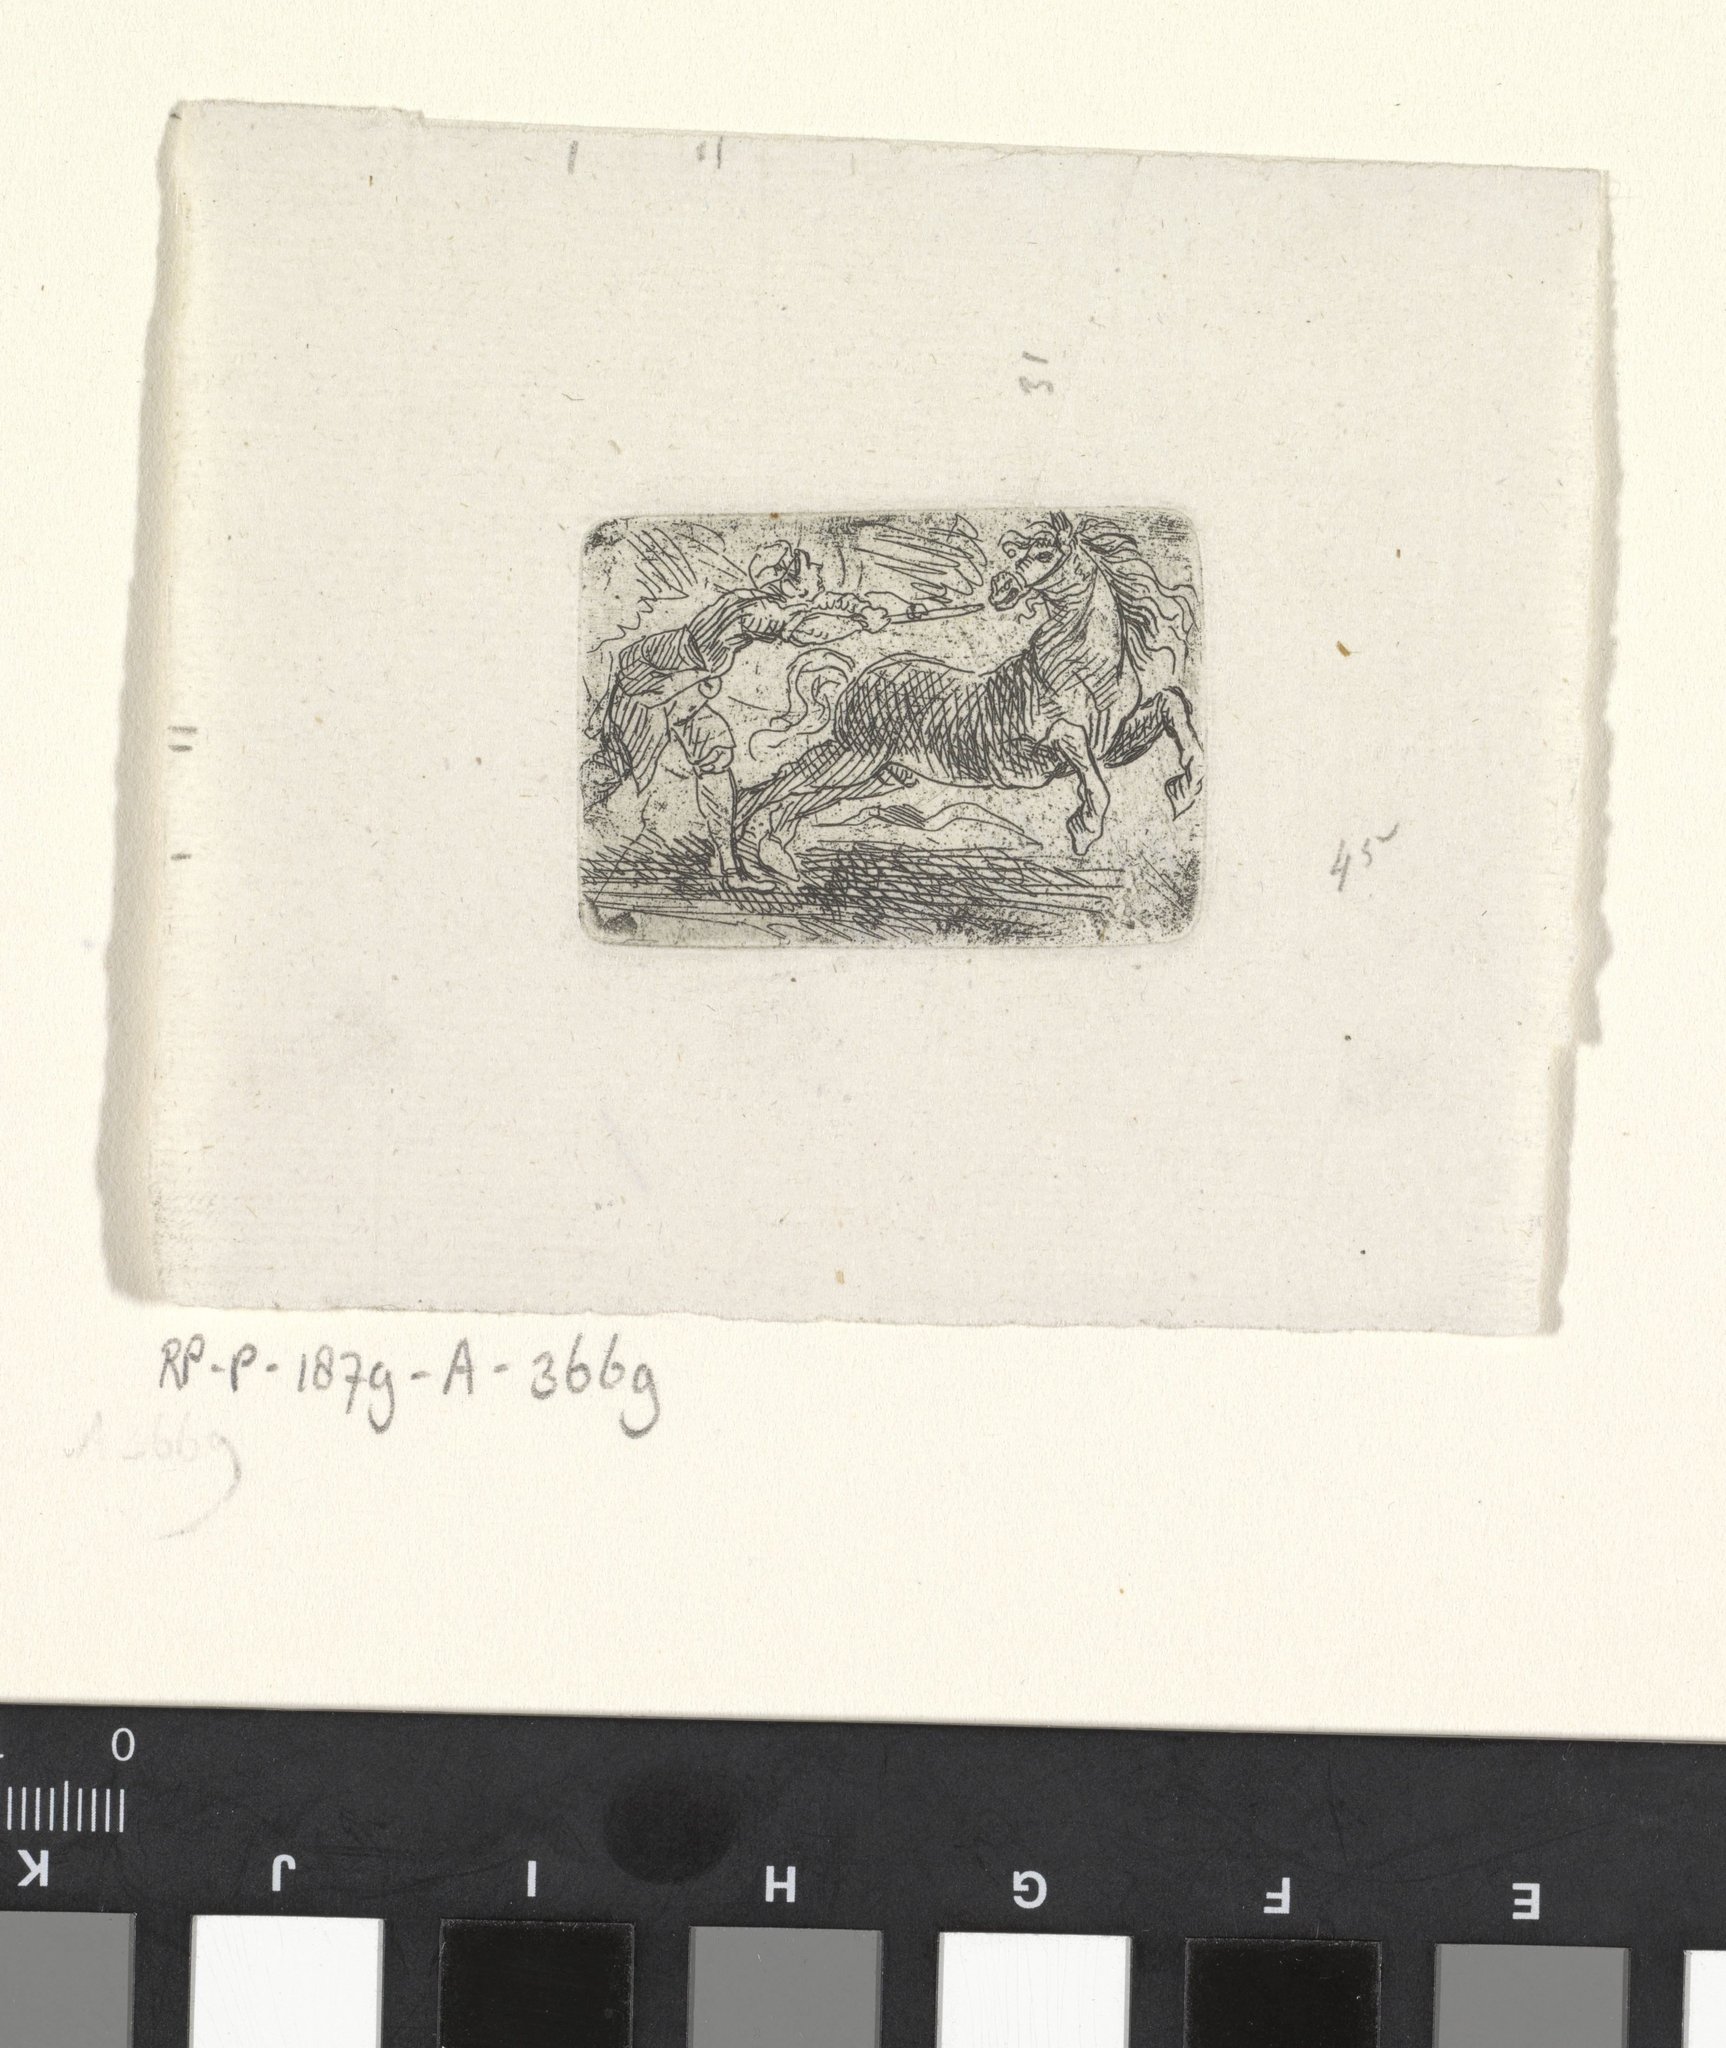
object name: print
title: Man die een naar hollend paard tracht te beteugelen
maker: Anonymous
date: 1550-1650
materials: paper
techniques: etching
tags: horse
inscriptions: collector's mark: Lugt 2227